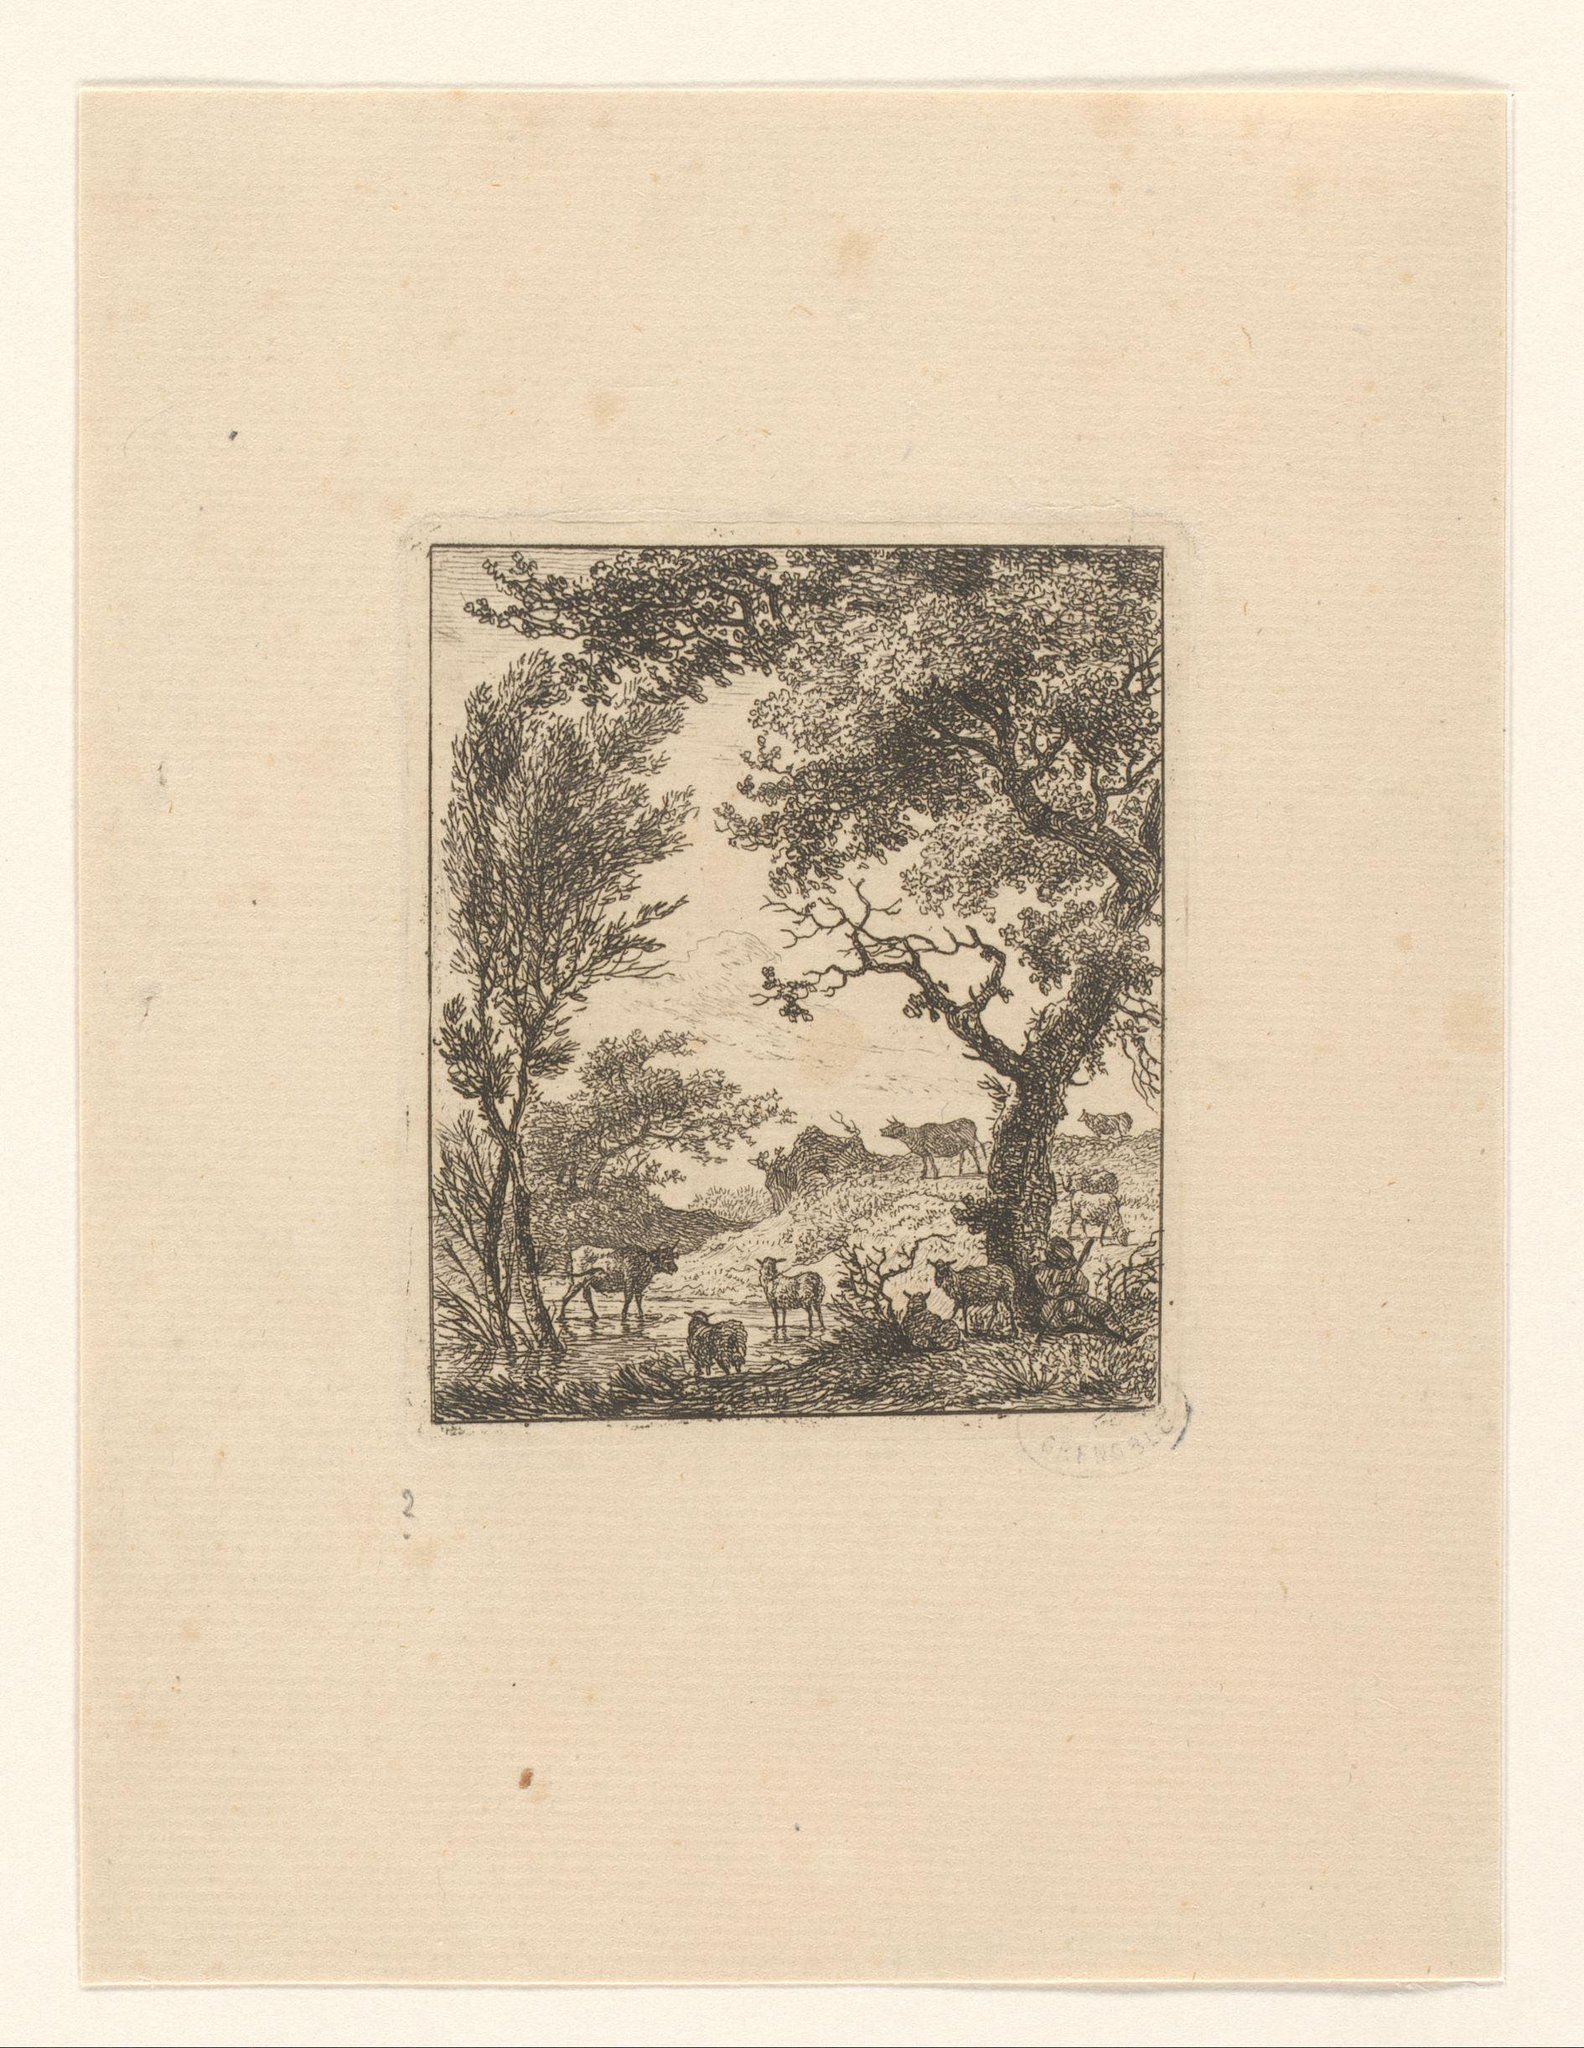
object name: print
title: Landschap met kudde vee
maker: hermanus fock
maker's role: conservator, draughtsman, painter, print maker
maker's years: 1766-1822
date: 1781-1822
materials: paper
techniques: etching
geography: amsterdam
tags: herding, herdsman, herdswoman, shepherd, shepherdess, cowherd, etc., pond, pool, herd, flock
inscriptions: collector's mark: Lugt 2228, inscription: ‘Jacob Cats? 1741-1799’, collector's mark: Lugt 1102b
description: Een herder en een kudde koeien en schapen in een heuvelachtig landschap met bomen en ondiep water.